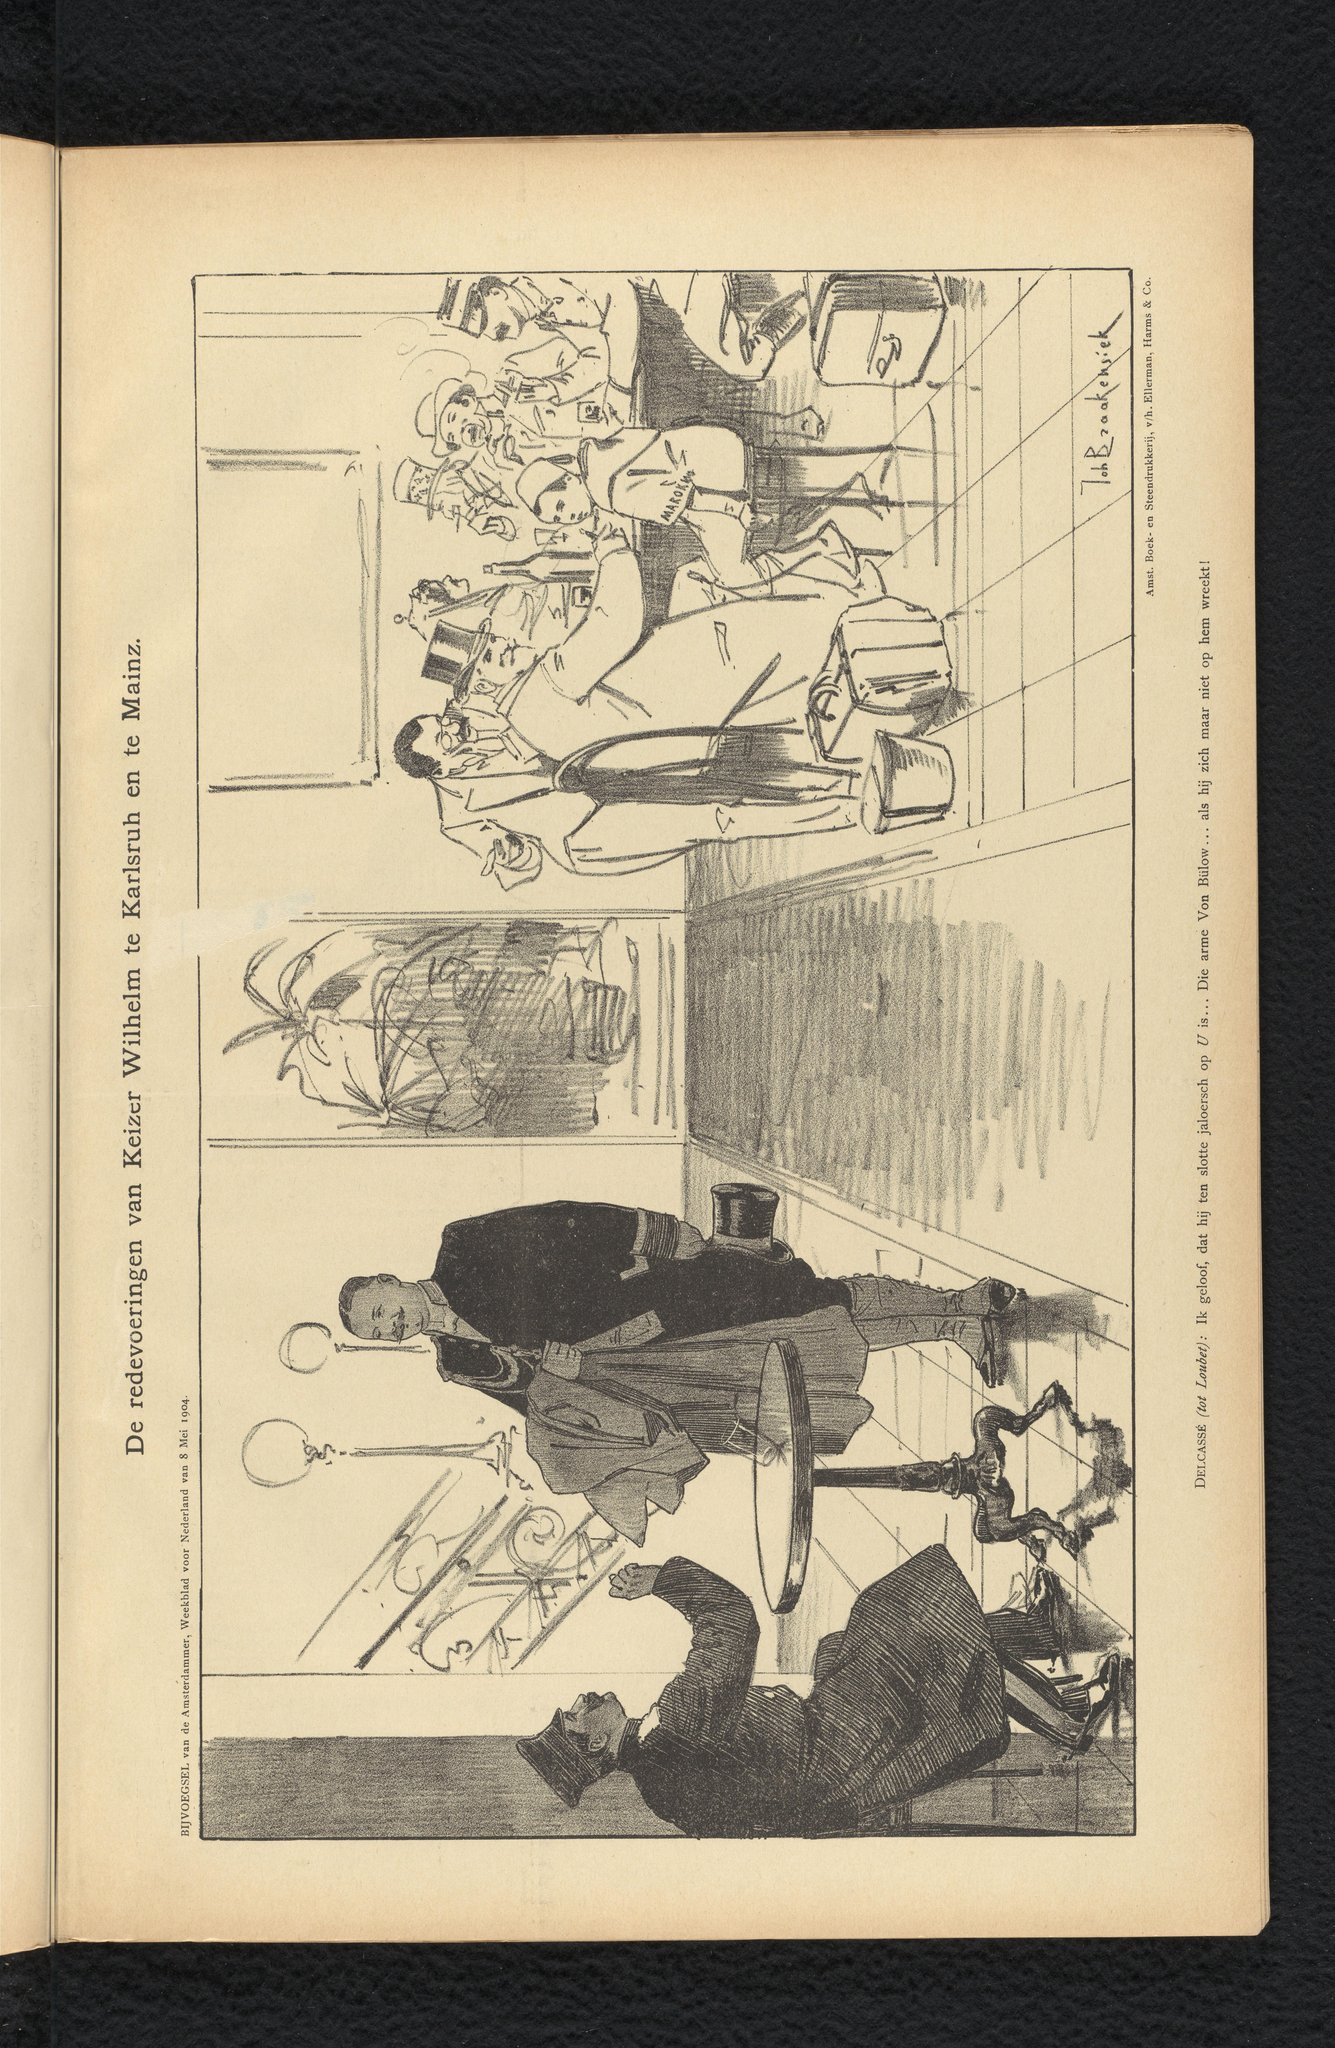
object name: cartoon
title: De redevoeringen van Keizer Wilhelm te Karlsruh en te Mainz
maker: johan braakensiek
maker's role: draughtsman, print maker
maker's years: 1858-1940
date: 1904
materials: paper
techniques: lithograph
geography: amsterdam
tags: wilhelm ii (keizer van duitsland), personifications of countries, nations, states, districts, etc., restaurant (+ waiter, waitress, etc.), restaurant, political caricatures and satires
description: Keizer Wilhelm II alleen zittend aan een tafeltje wordt bediend door ober Bernhard von Bülow. Aan een ander tafeltje zitten de andere grote mogendheden gezellig samen met Marokko, de Franse minister van Buitenlandse Zaken Delcassé spreekt, wijzend naar de Duitse keizer, tot de Franse president Loubet.